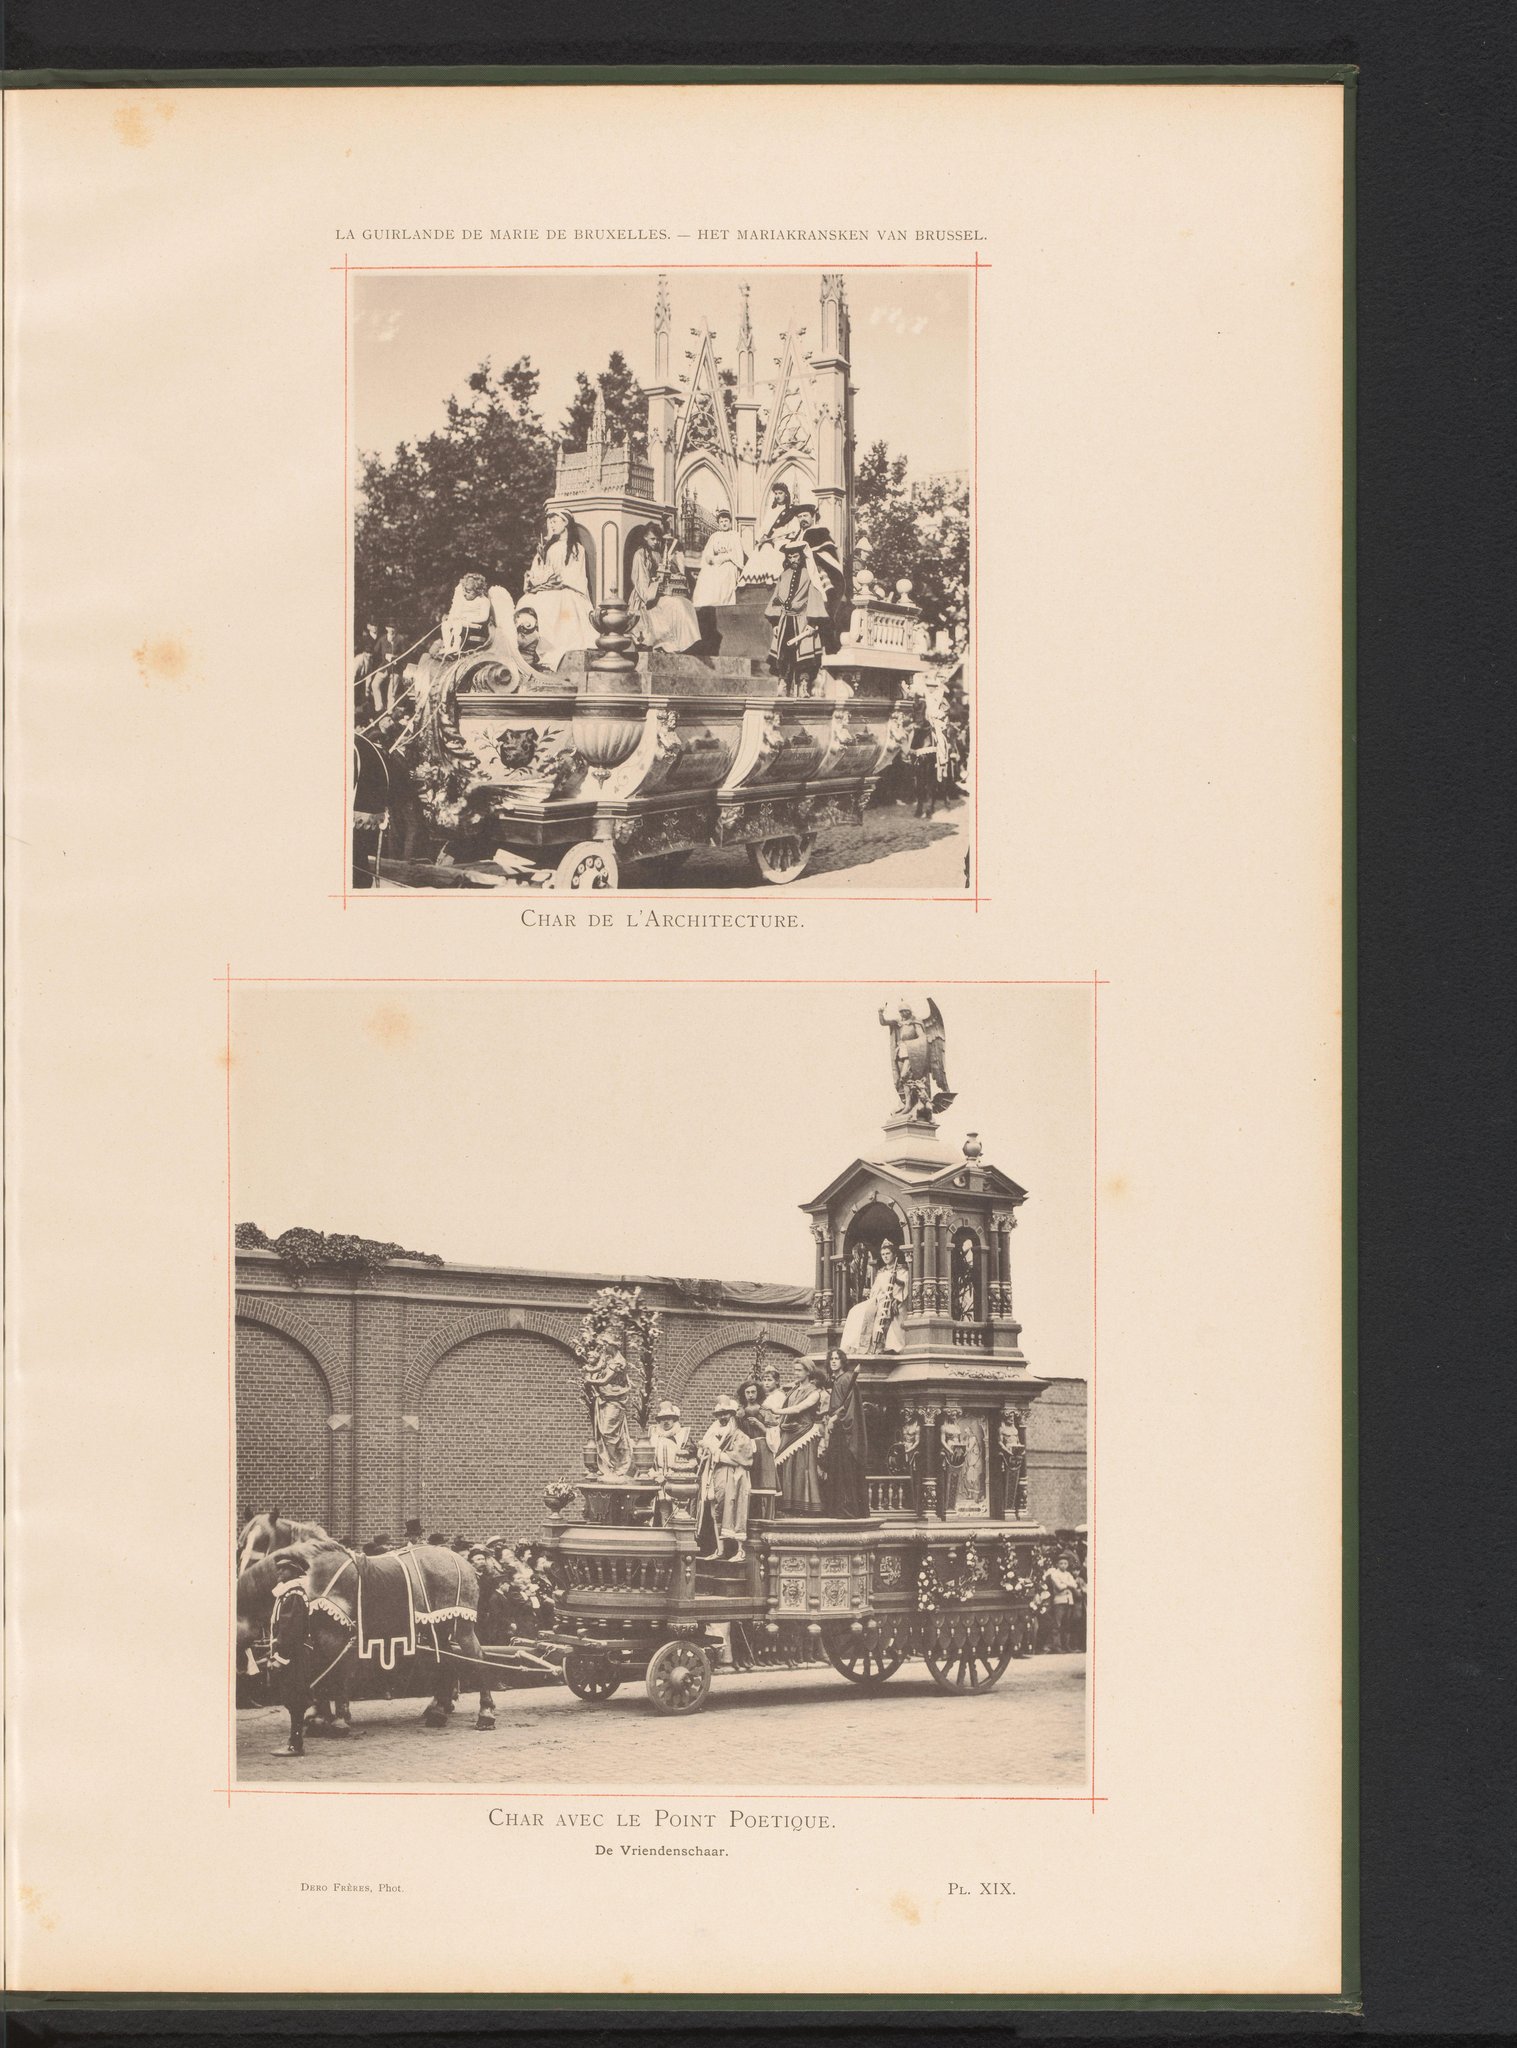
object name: page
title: Char de l'Architecture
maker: joseph maes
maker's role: fotograaf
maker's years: 1838-1908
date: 1892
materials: paper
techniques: photograph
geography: antwerp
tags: public festivities (+ parade, pageant, cavalcade ~ festive activities), antwerp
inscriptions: inscription: ‘De Vriendenschaar.’, inscription: ‘LA GUIRLANDE DE MARIE DE BRUXELLES. - HET MARIAKRANSKEN VAN BRUSSEL.’, number: ‘Pl. XIX.’